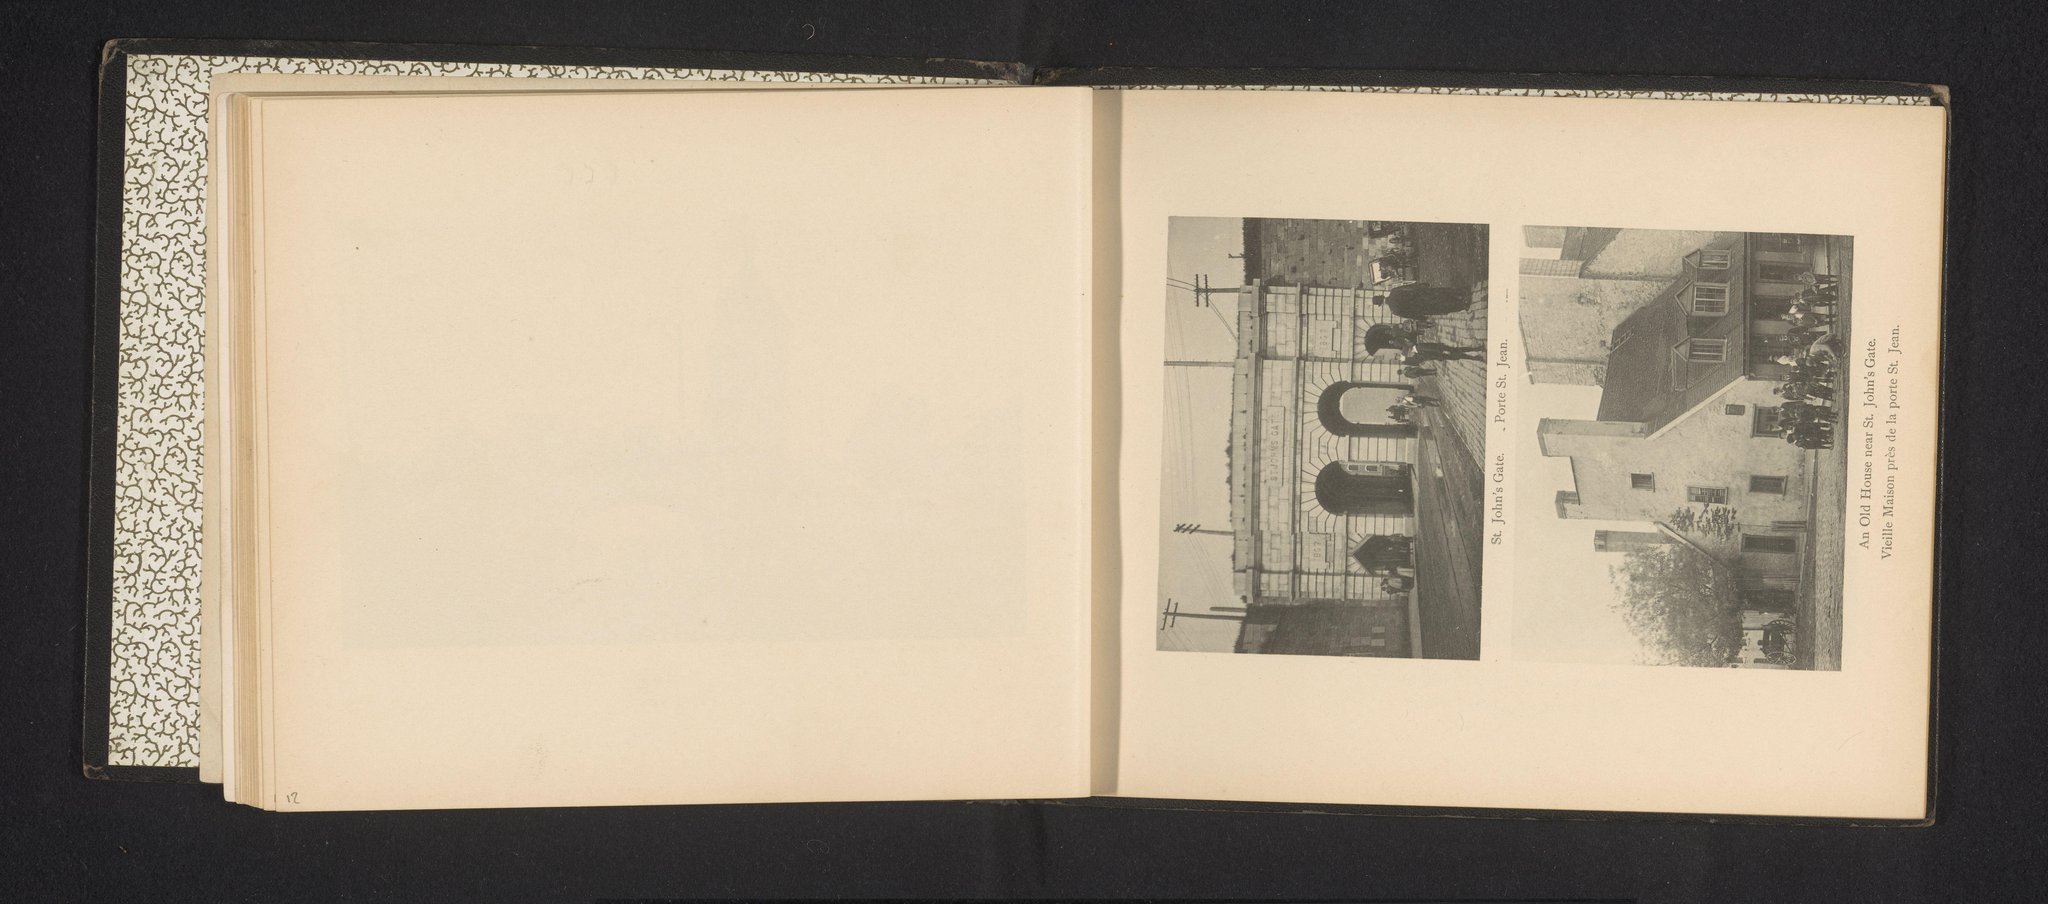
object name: page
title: An Old House near St. John's Gate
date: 1889-1894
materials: paper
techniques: photograph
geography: quebec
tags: urban housing, anonymous historical persons portrayed in a group, in a group-portrait, québec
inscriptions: inscription: ‘Veille Maison près de la porte St. Jean’